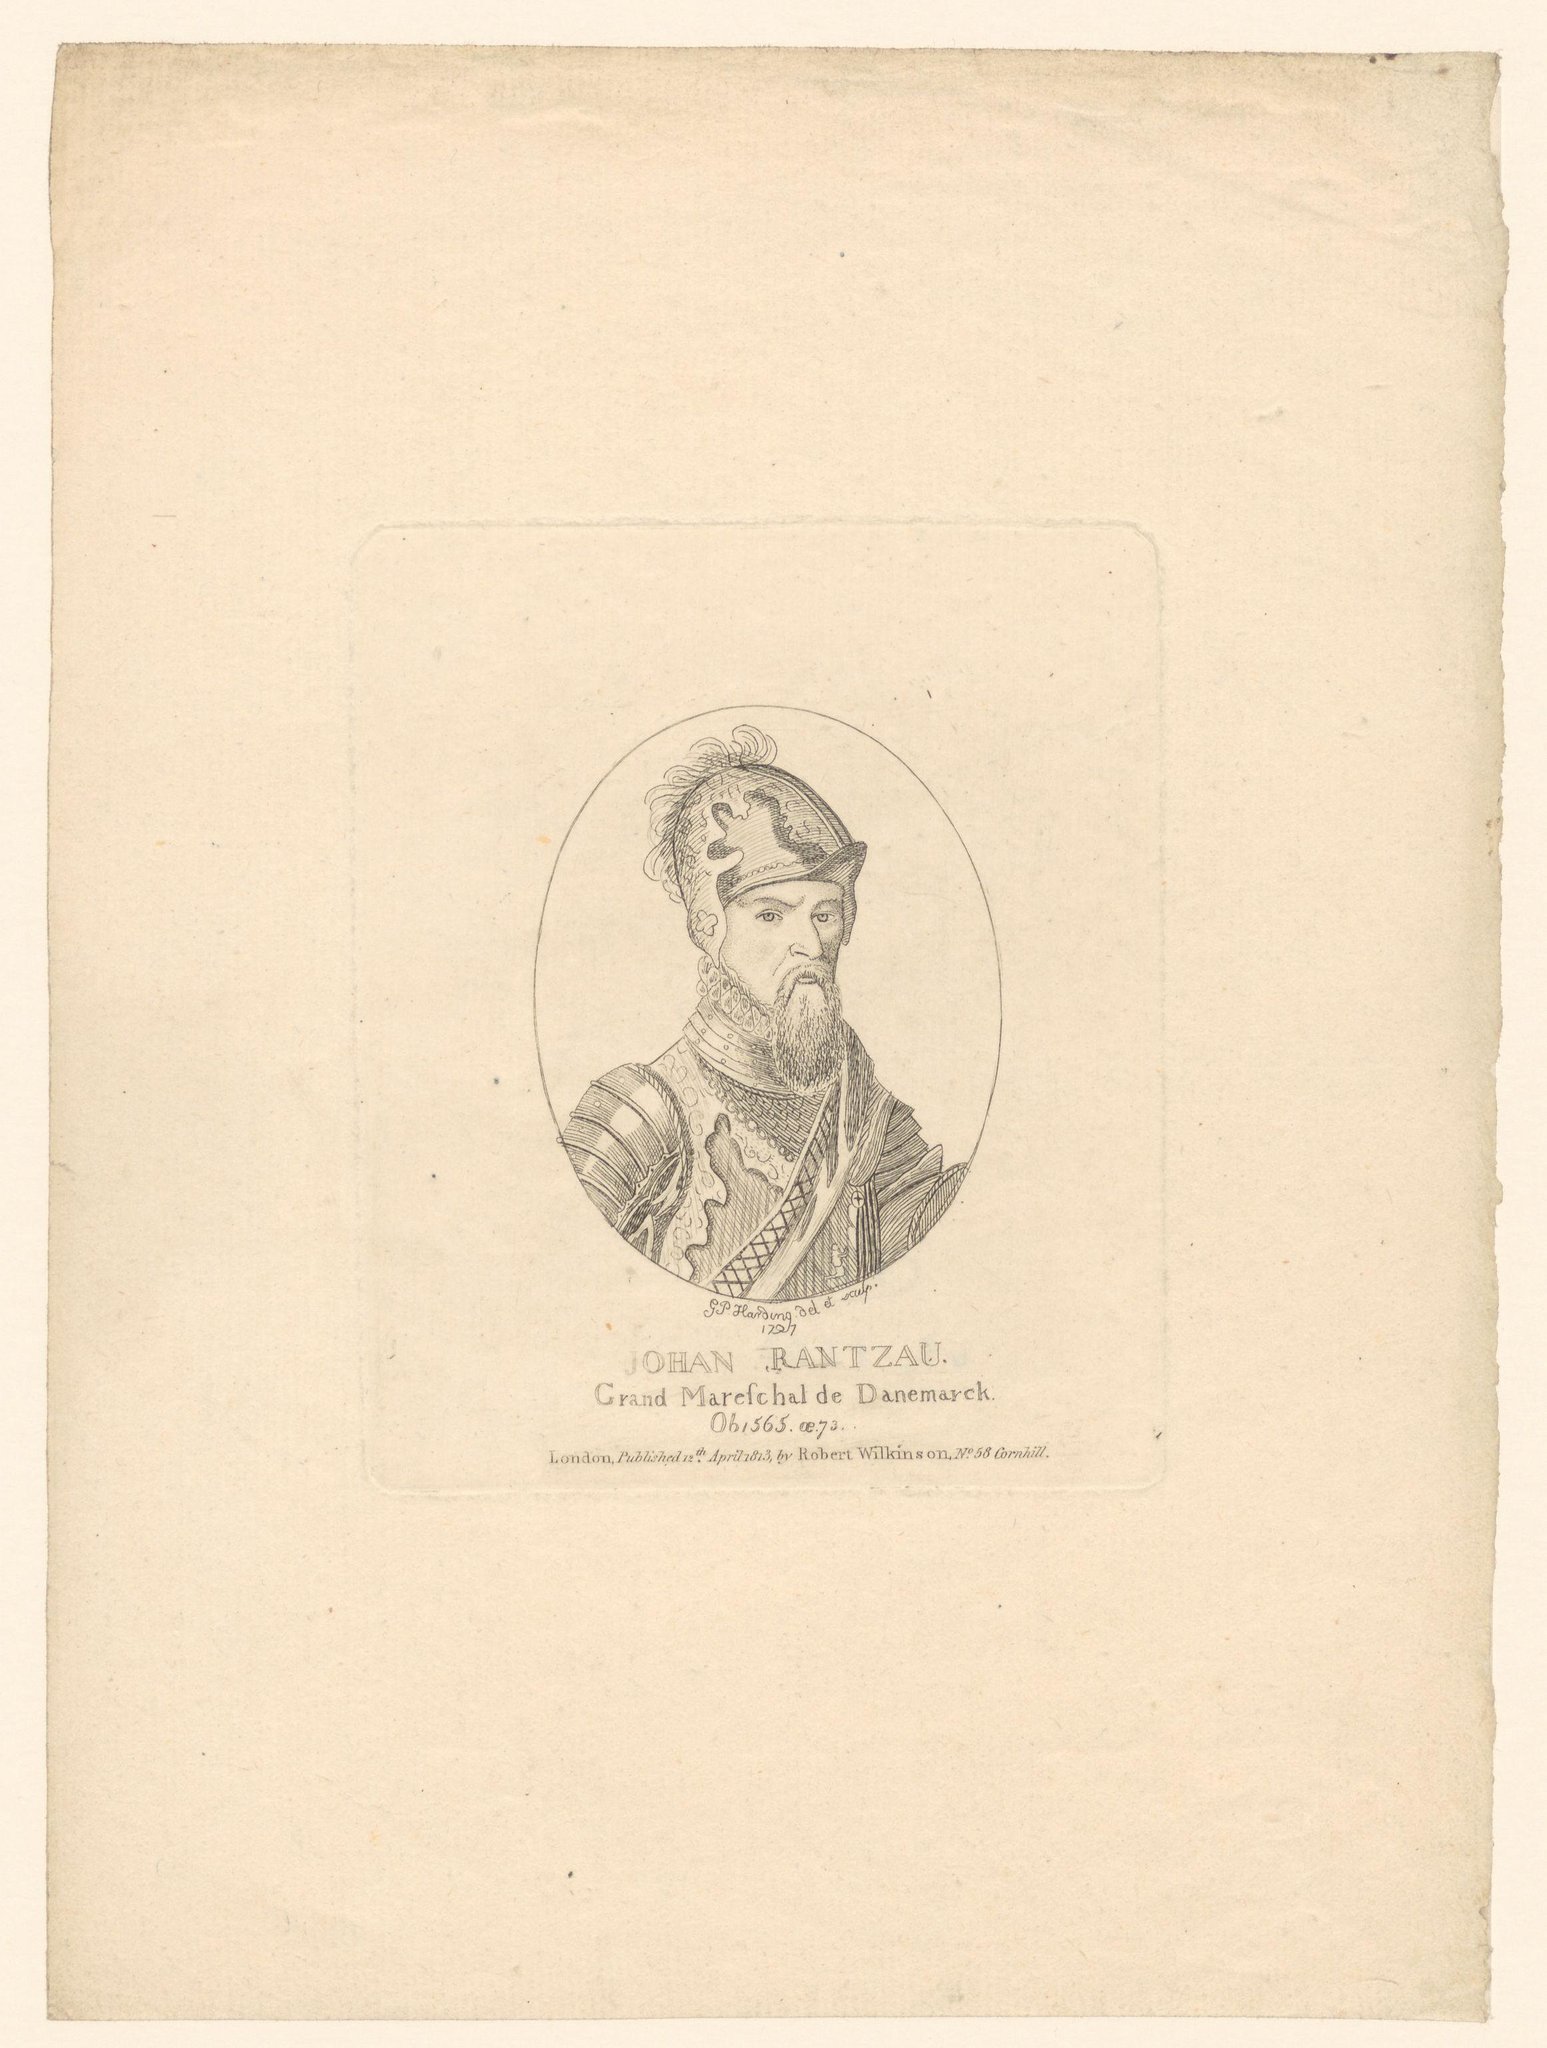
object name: print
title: Portret van Johan Rantzau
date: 1797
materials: paper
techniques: etching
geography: london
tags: commander-in-chief, general, marshal, historical persons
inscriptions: collector's mark: Lugt 2228